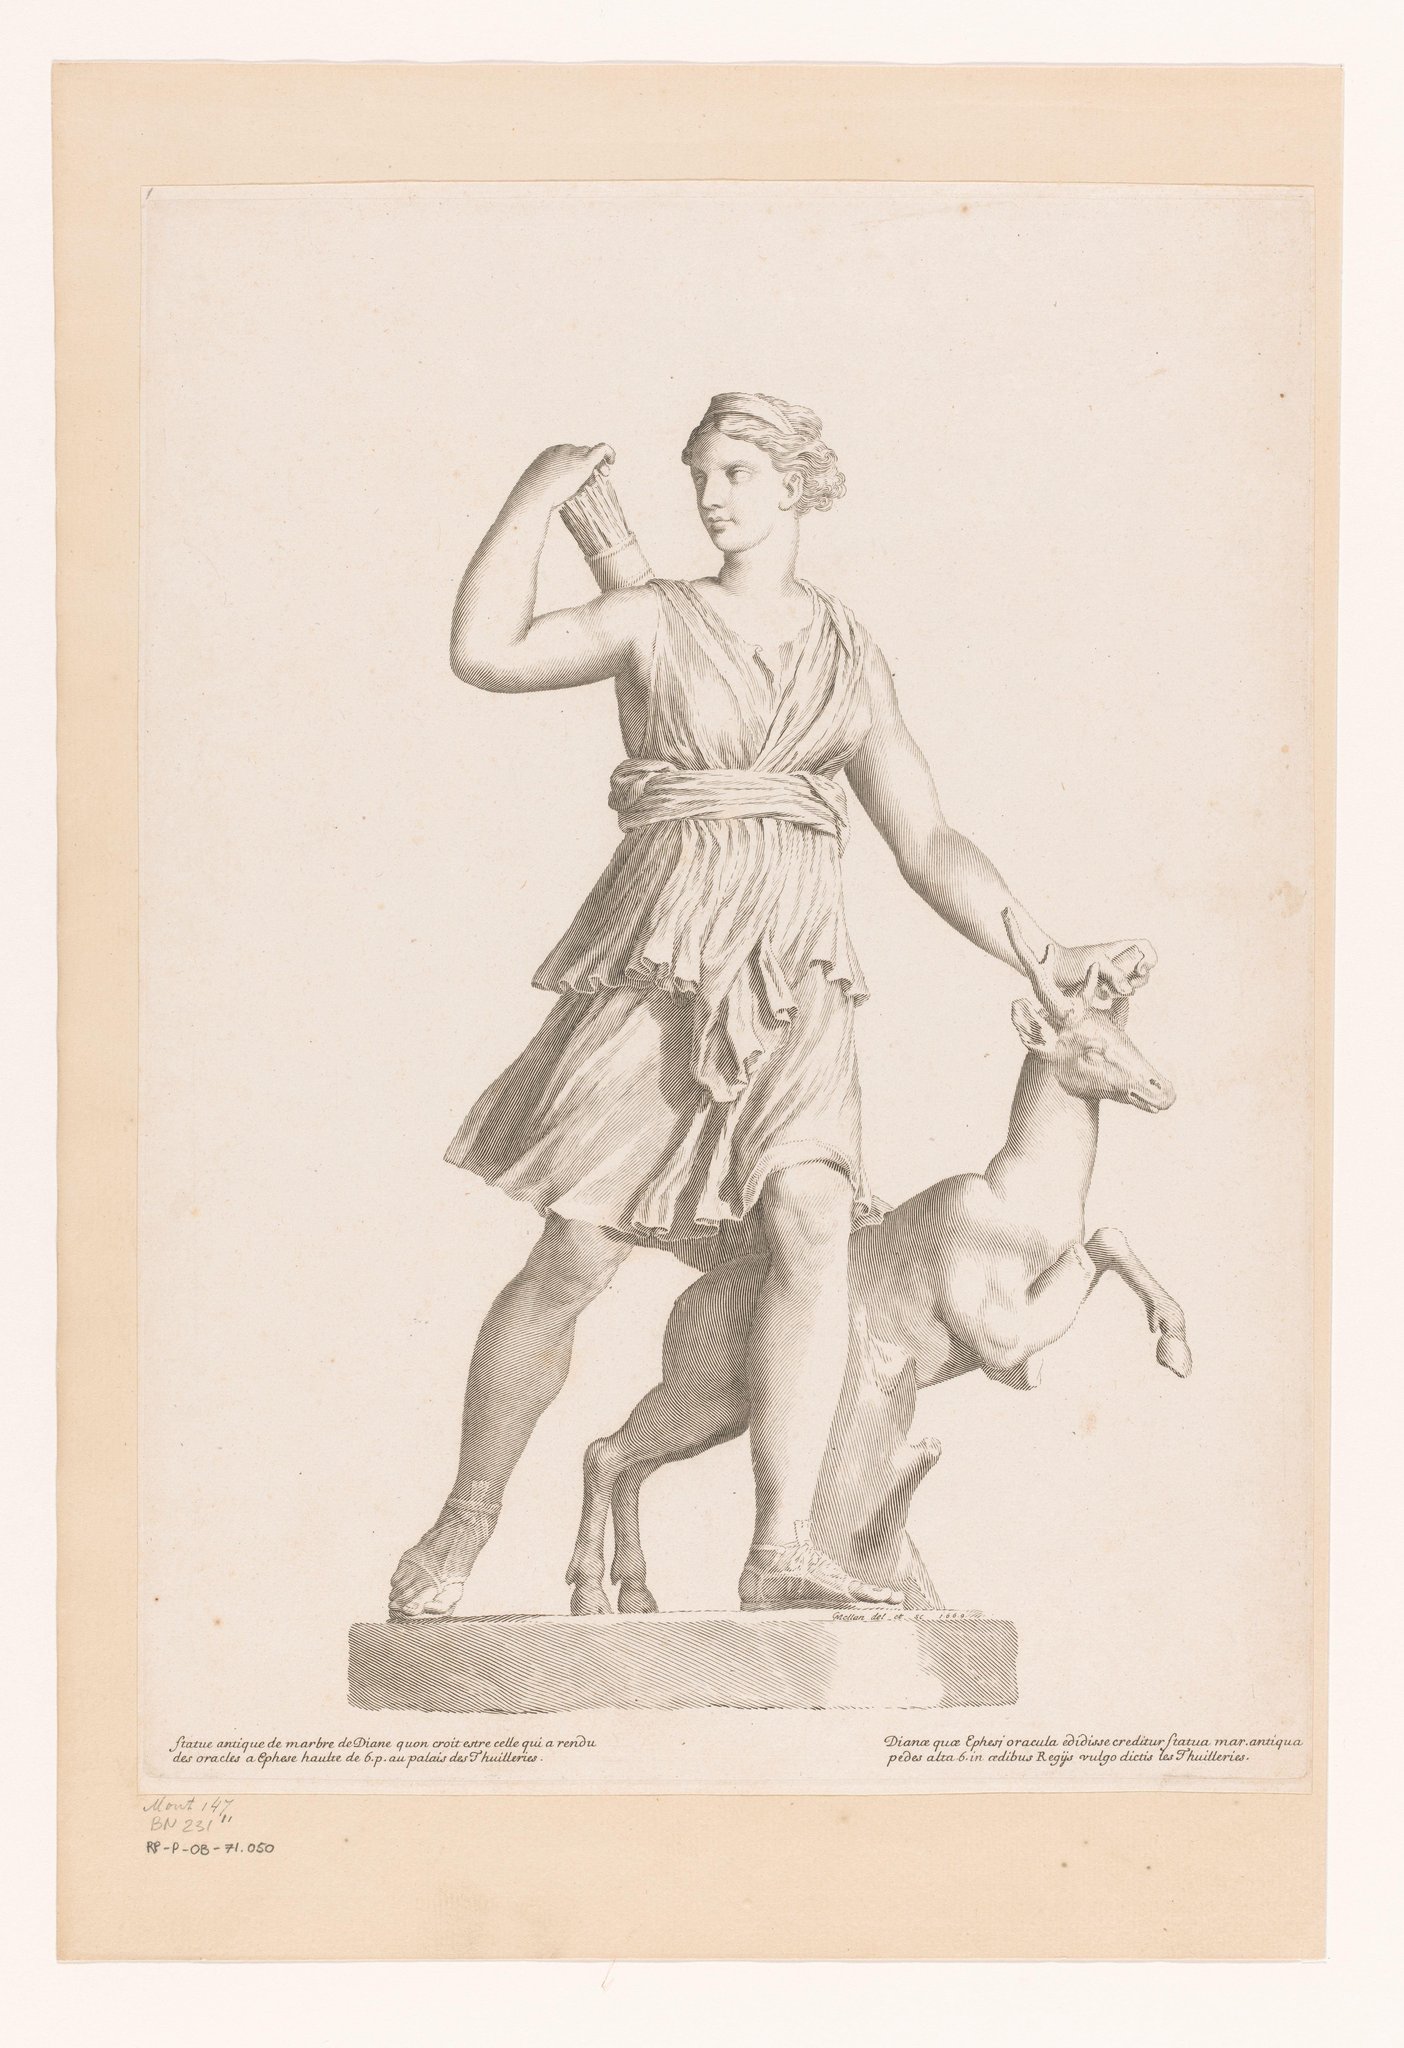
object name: book illustration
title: Standbeeld van Diana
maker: claude mellan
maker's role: draughtsman, print maker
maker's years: 1598-1688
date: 1669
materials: paper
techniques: engraving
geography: france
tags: diana hunting, piece of sculpture, reproduction of a piece of sculpture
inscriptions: collector's mark: Lugt 240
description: Prent gebruikt voor: Félibien, André. Tableaux du Cabinet du roy. Statues et bustes antiques des maisons royales. Parijs: Imprimerie Royale, 1677. Het boek bevat 61 prenten van beelden en bustes uit Franse koninklijke collectie. Mellan vervaardigde in totaal achttien platen. Het beeld, bekend als de 'Diana de Versailles', bevindt zich sinds 1798 in het Musée du Louvre te Parijs, inv.nr. 926.